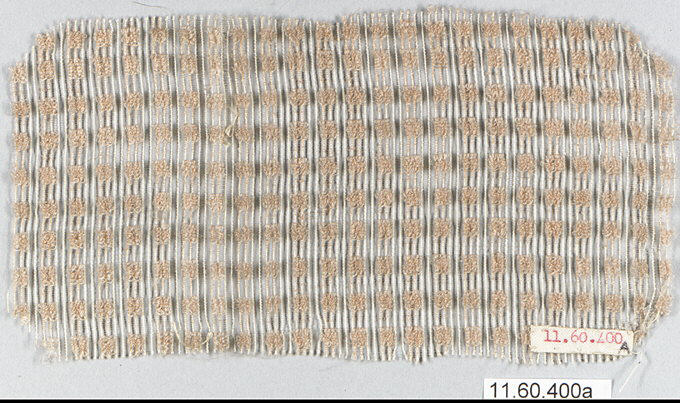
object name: fragment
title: Fragments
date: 1801-1900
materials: silk